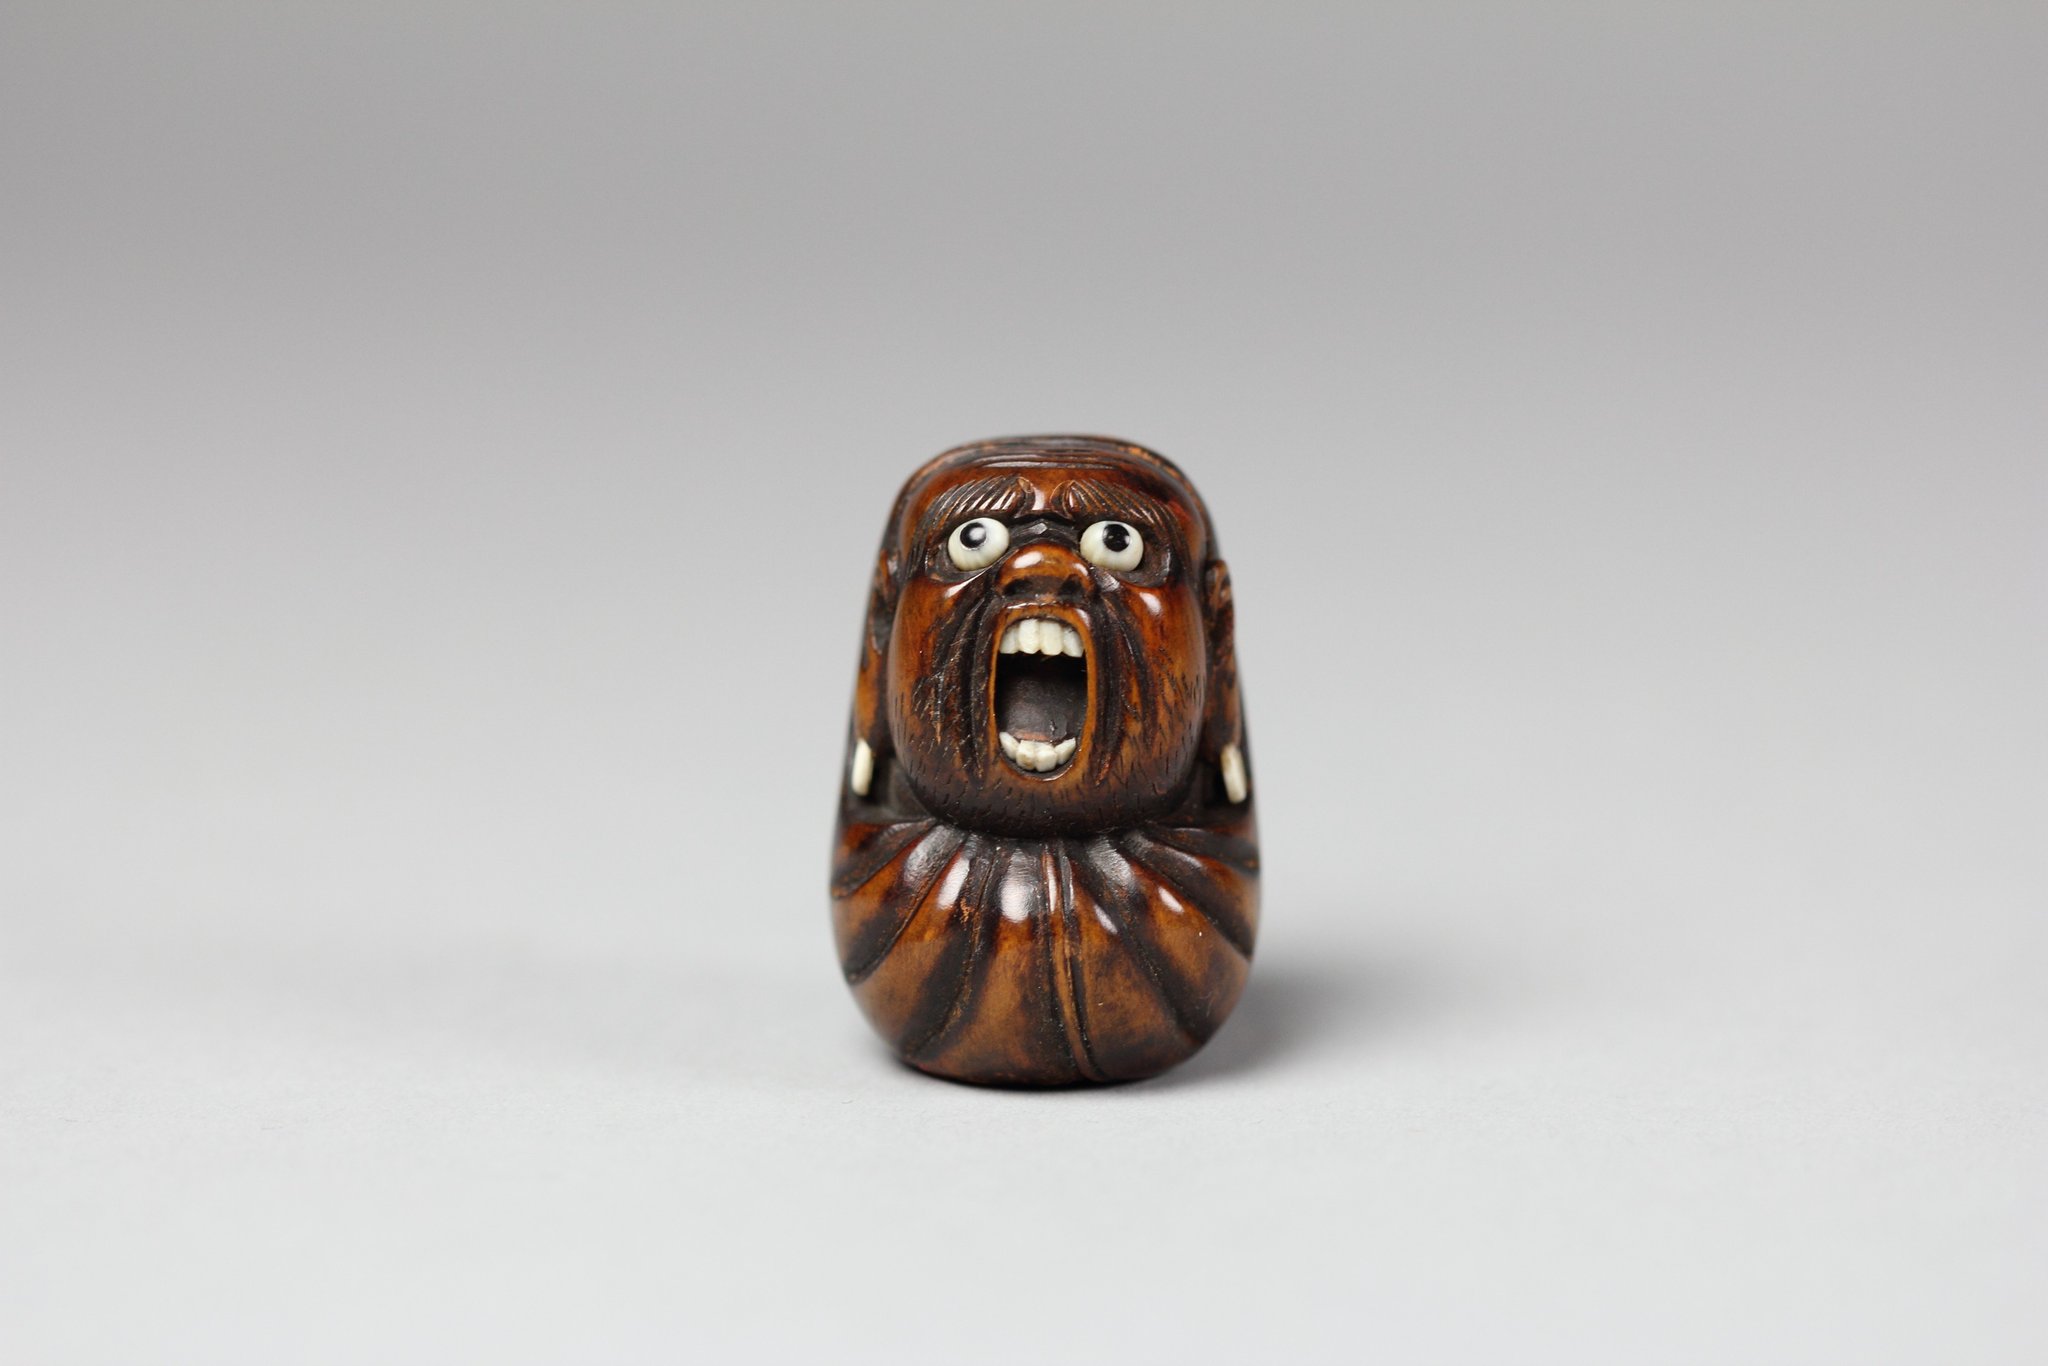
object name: netsuke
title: Netsuke of Head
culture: japanese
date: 1801-1900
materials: ivory, wood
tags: heads